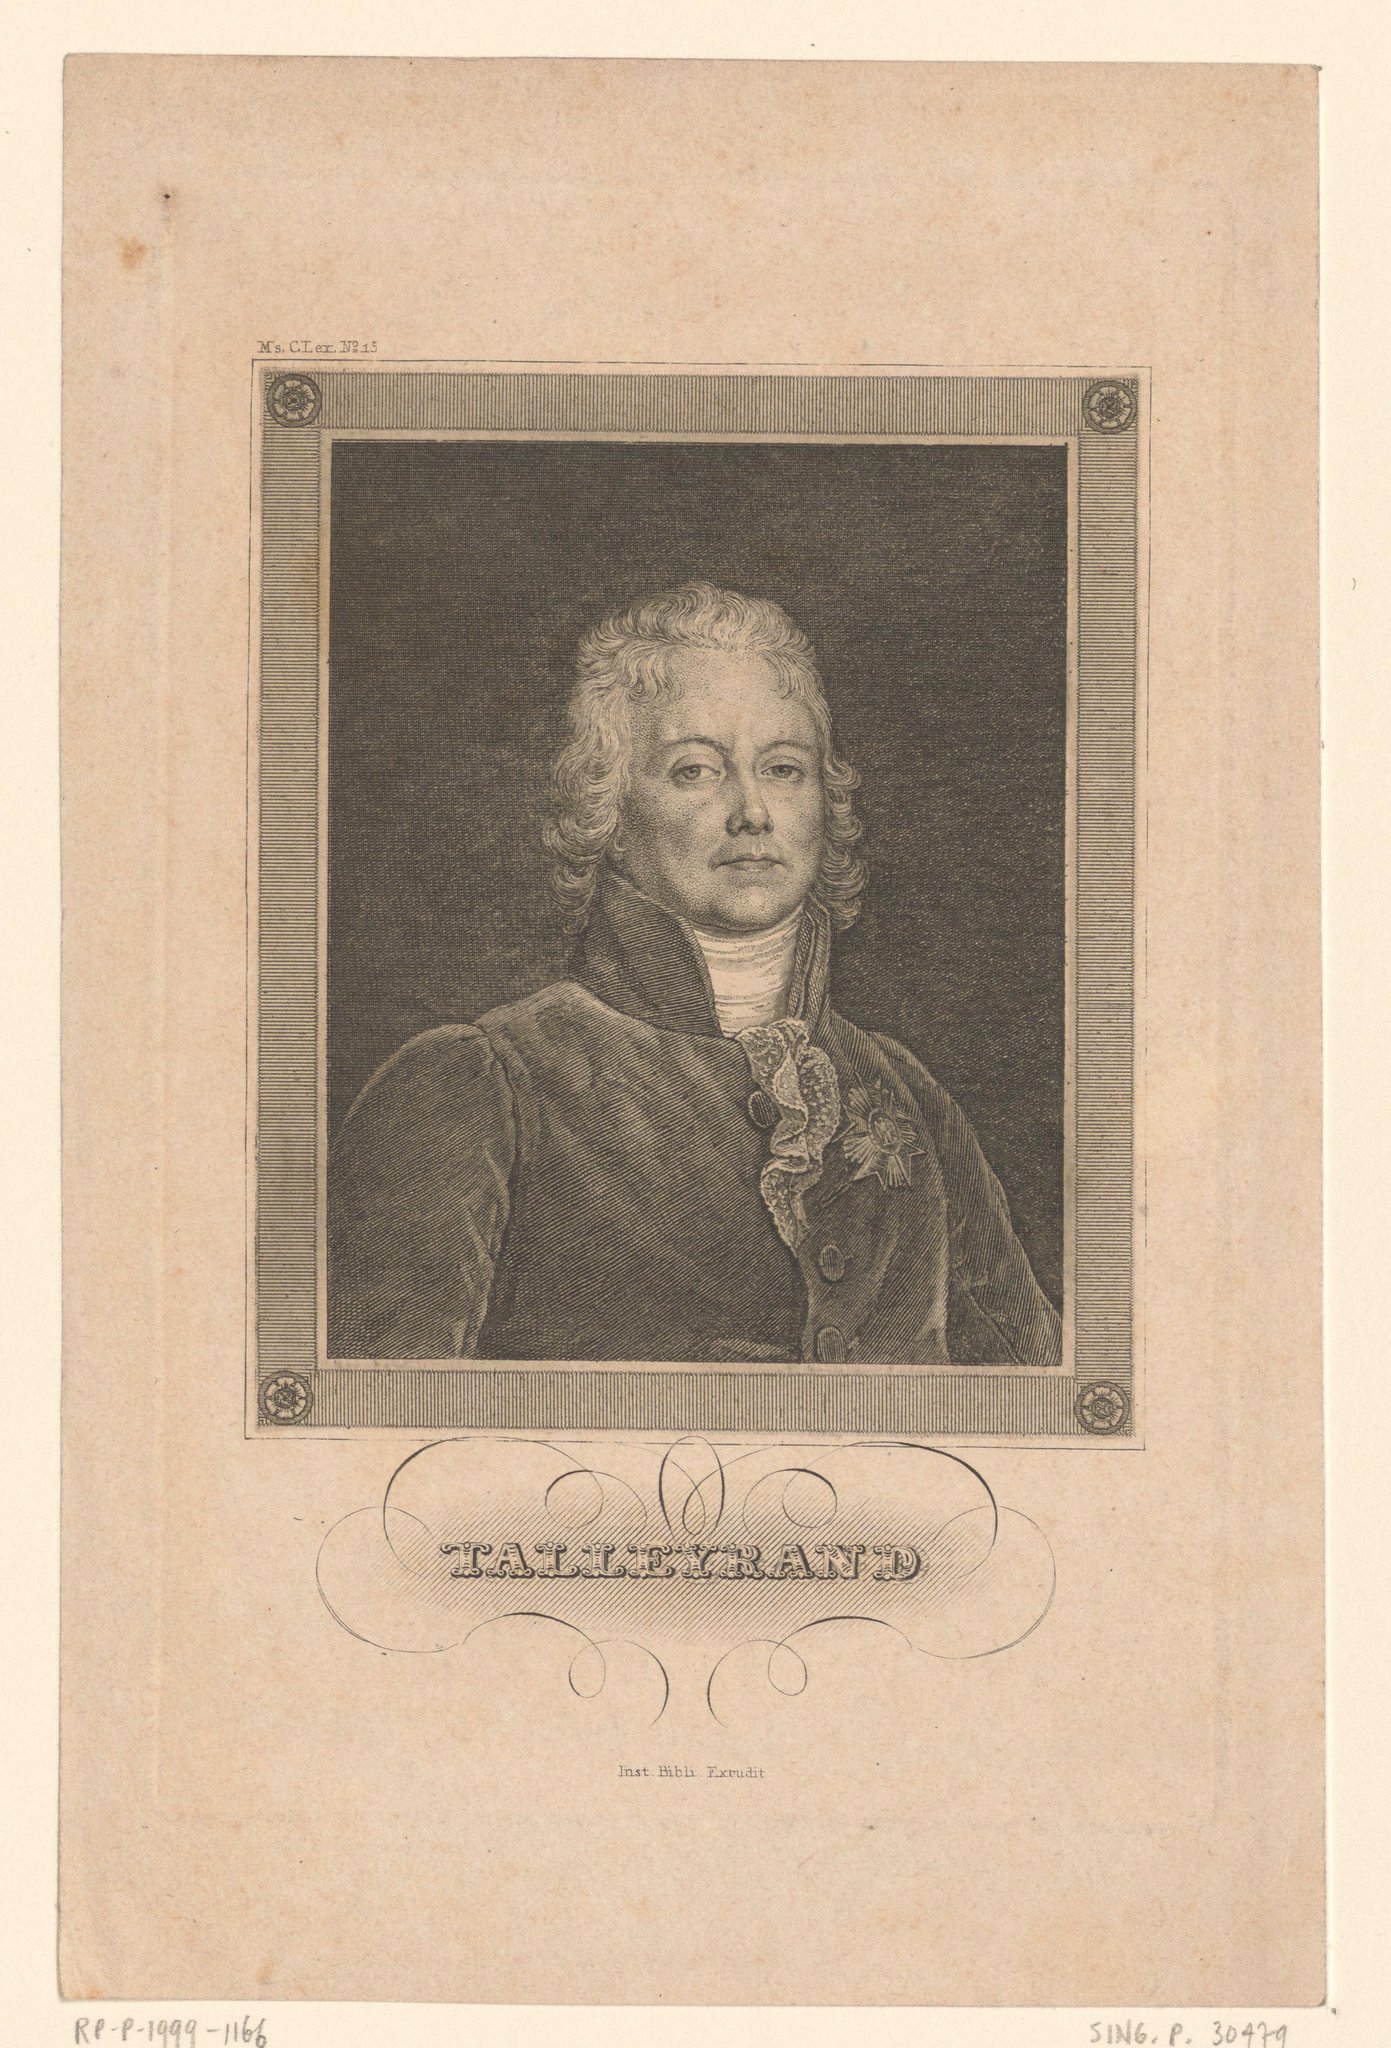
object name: print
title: Portret van Charles Maurice de Talleyrand-Périgord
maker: Anonymous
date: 1840-1855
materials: paper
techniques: engraving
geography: hildburghausen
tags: paris, politician, charles maurice hertog van talleyrand-périgord, historical persons, politician, e.g. party leader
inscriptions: collector's mark: Lugt 2228, collector's mark: Lugt 2760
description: Prent uit: Meyer, Joseph. Das Grosse Conversations-Lexikon für die gebildeten Stände. Hildburghausen: Bibliographisches Institut, 1840-1855.